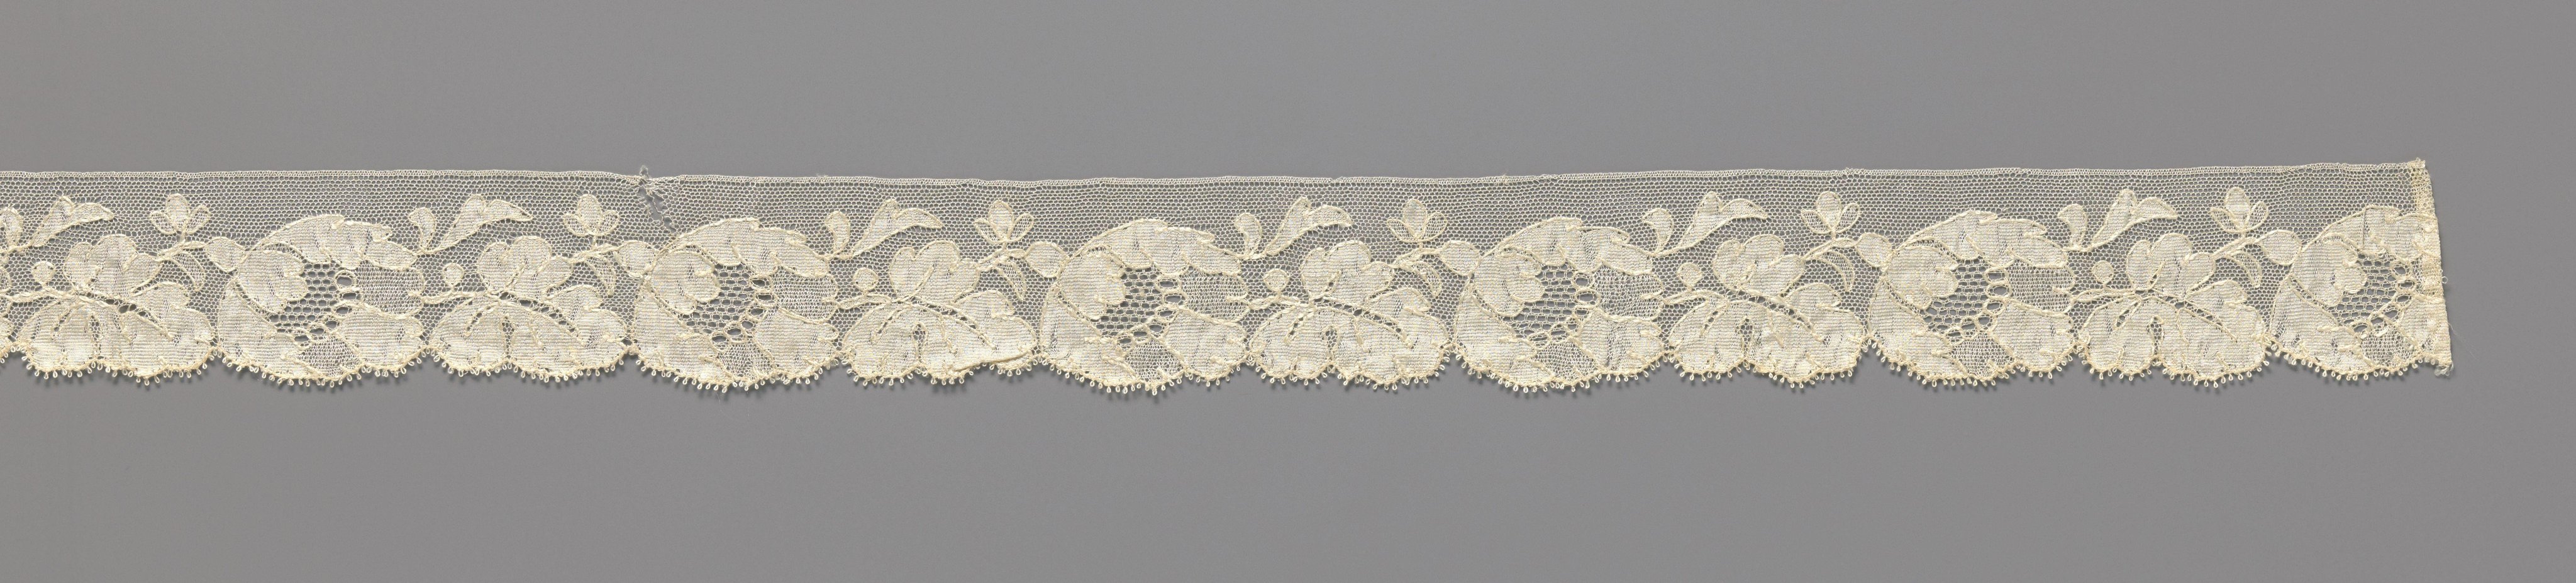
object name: strip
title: Strook machinale kant met liggende bloem gevolgd door een liggend blad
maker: Anonymous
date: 1850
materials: silk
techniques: lace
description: Strook naturelkleurige machinale kant: machinale blonde. Het zich herhalende patroon bestaat uit een liggende bloem gevolgd door een liggend blad en enkele kleinere bladertakken. De bloemen en bladeren zorgen voor een schulpenrand langs de onderzijde van de strook. De motieven zijn voorzien van dikke glimmende contourdraden en zijn met een traliegrond met elkaar verbonden, een machinale tulegrond. In de bloemharten is een siergrond toegepast, een machinale rozengrond. De bovenzijde van de strook is recht afgewerkt. De schulpenrand is afgewerkt met picots.